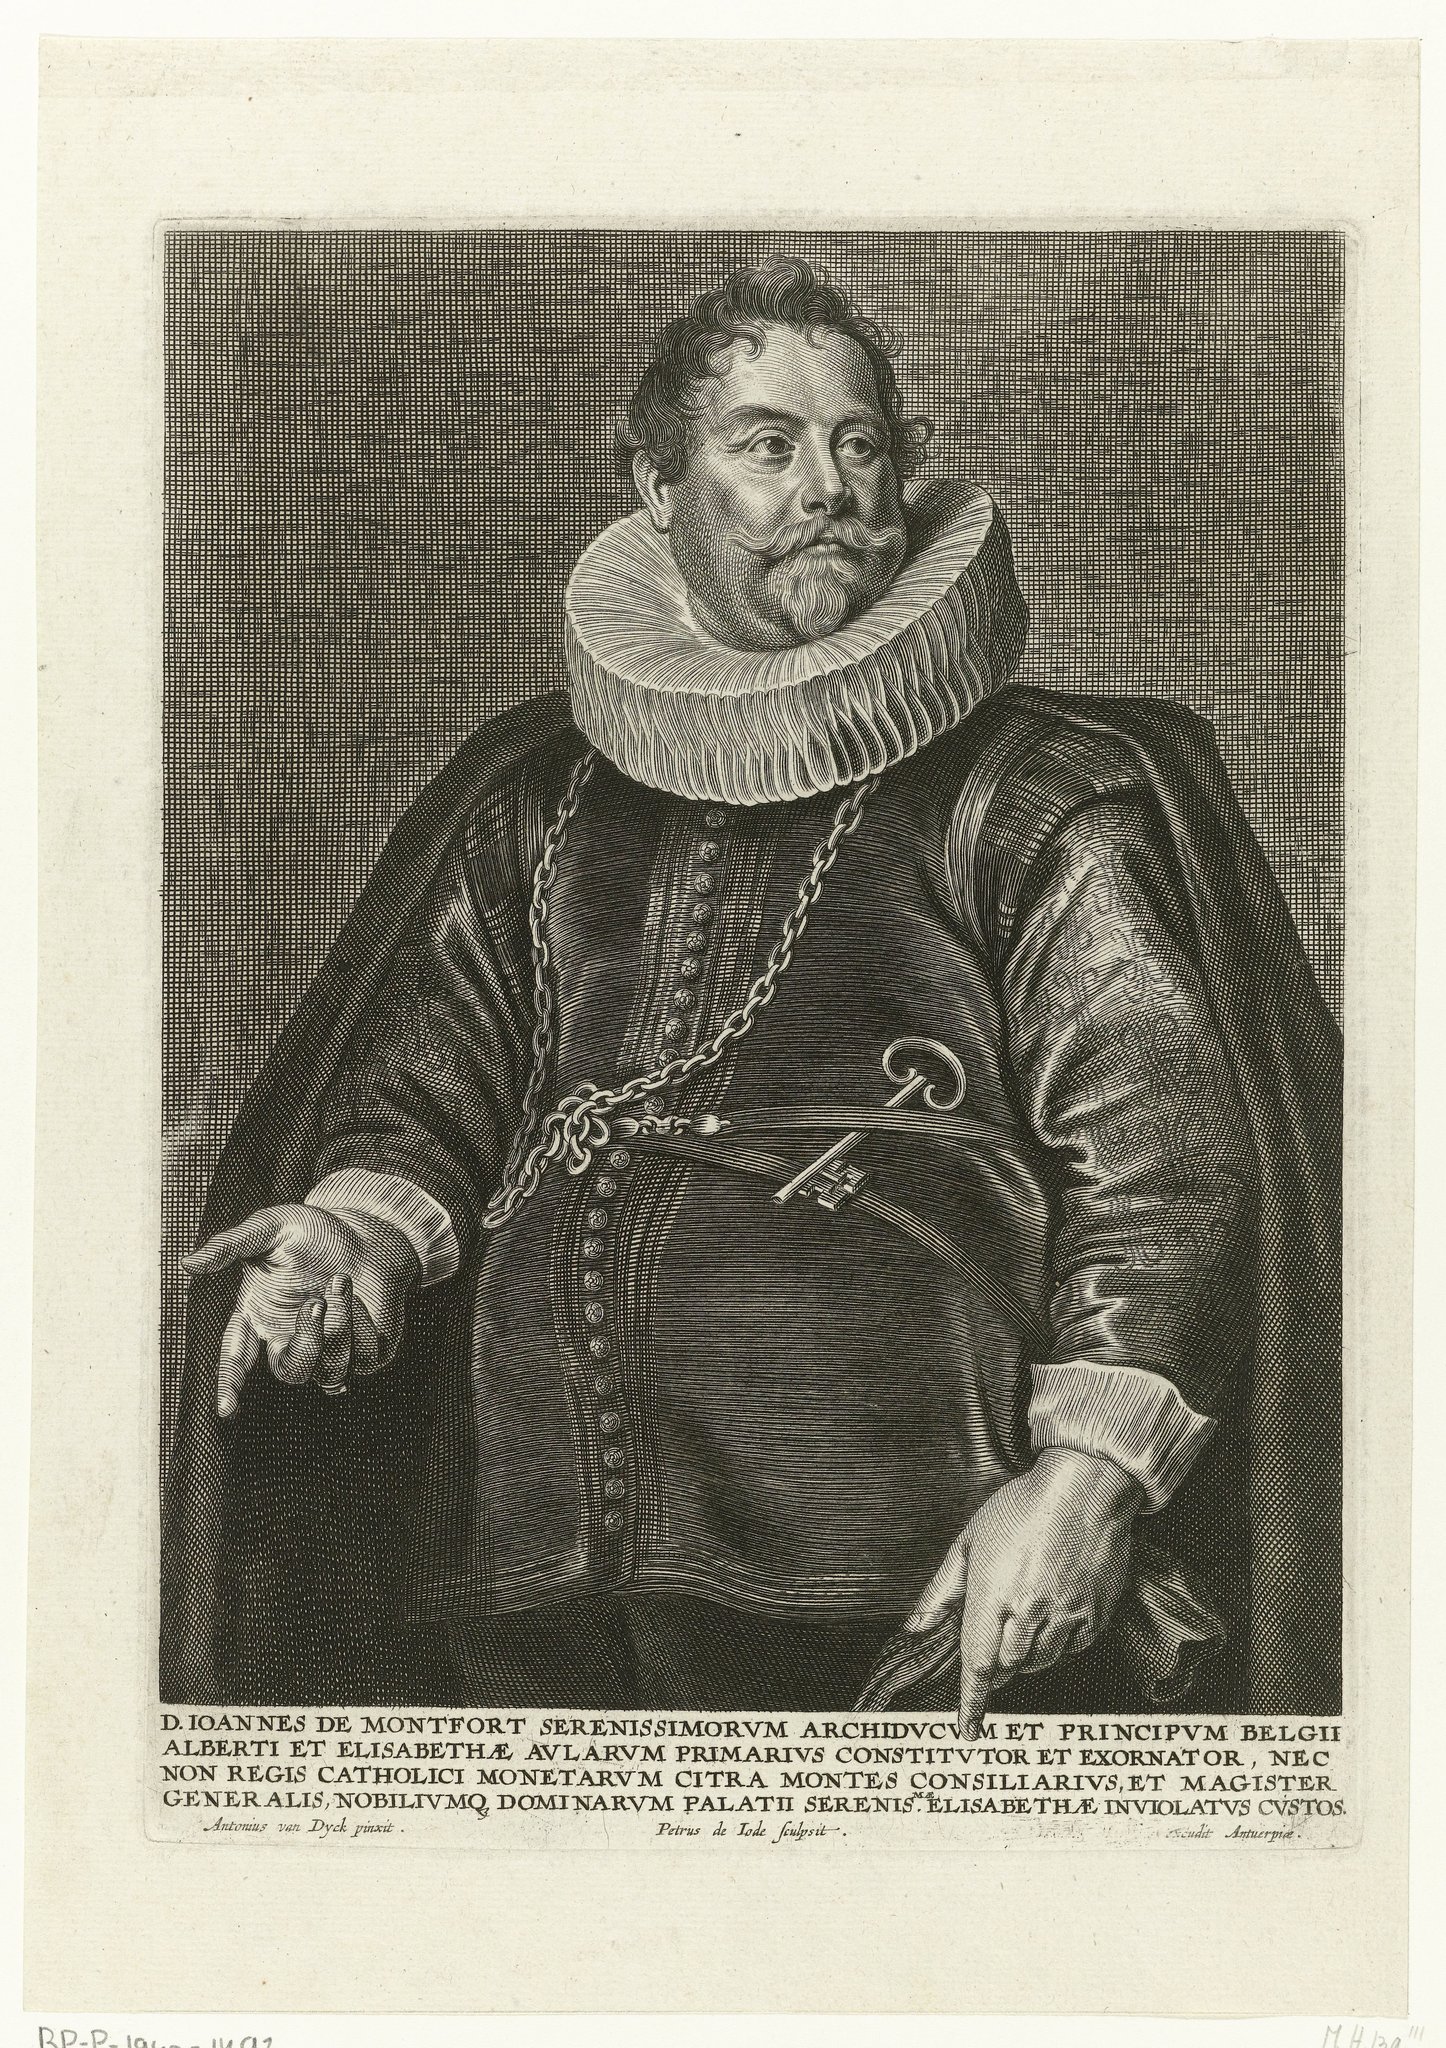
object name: print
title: Portret van Jan van Montfort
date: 1628-1670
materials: paper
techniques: engraving, etching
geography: antwerp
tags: key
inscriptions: collector's mark: Lugt 2760, collector's mark: Lugt 2166, collector's mark: Lugt 2228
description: Portret van Jan van Montfort, ten halven lijve. Hij draagt een sleutel in zijn bandelier. In de marge een vierregelig onderschrift in het Latijn.